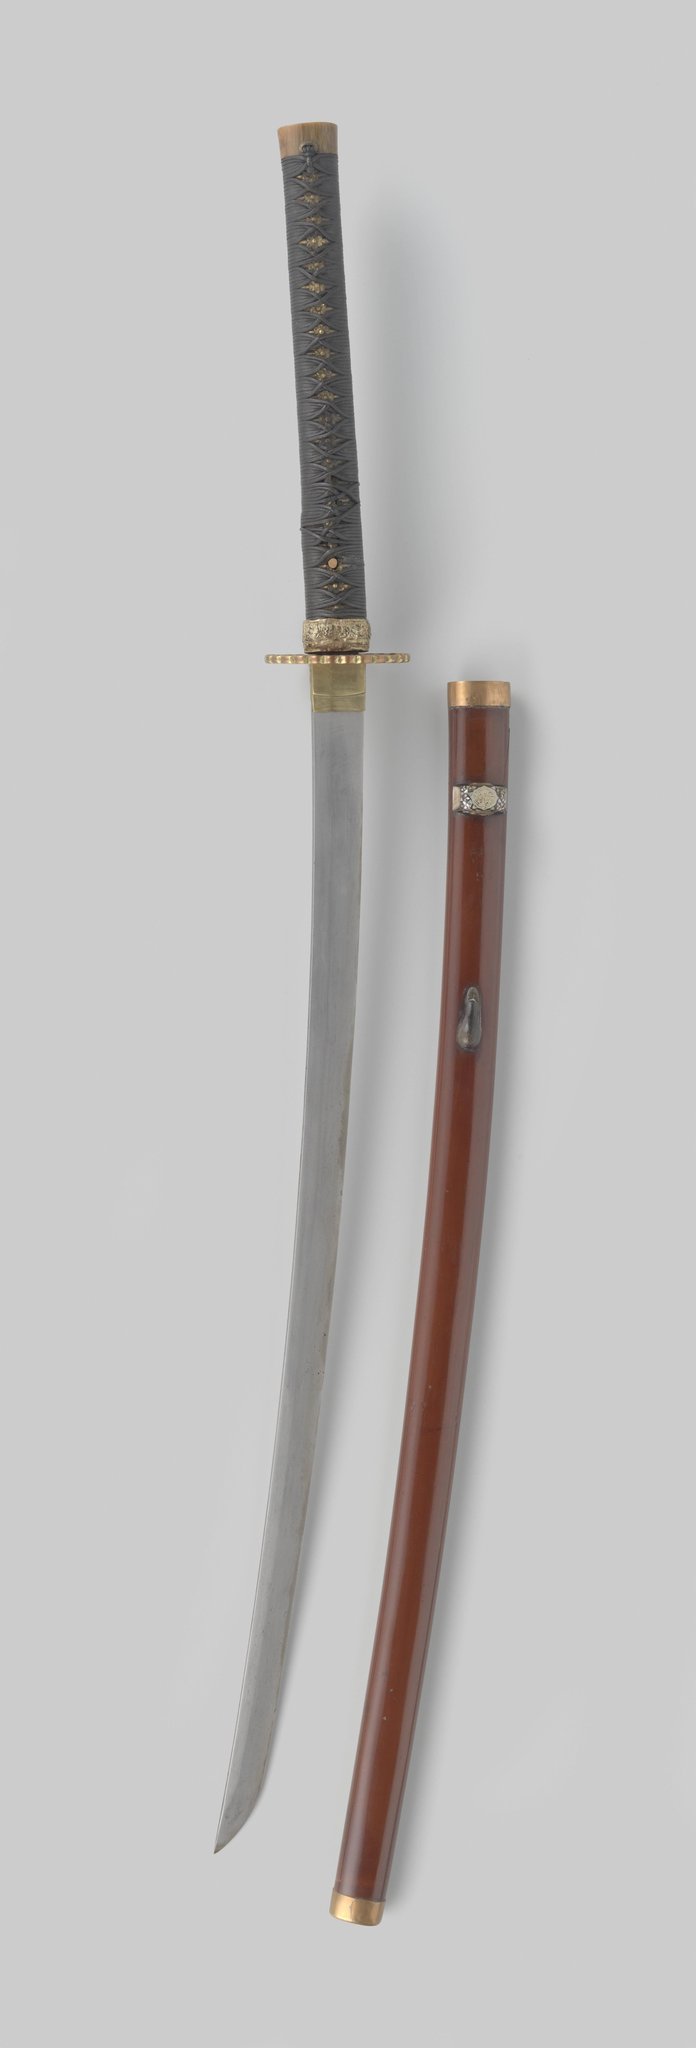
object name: katana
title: Sabel behorend bij wapenrek van Cornelis Tromp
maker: Anonymous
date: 1650-1679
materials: copper, wood, horn, mother of pearl, silk, steel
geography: north vietnam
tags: cornelis tromp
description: Arms collection of Cornelis Tromp. These weapons were kept at the Amsterdam home of Cornelis Tromp. The collection included contemporary weapons of exceptional quality and several exotic weapons acquired for their curiosity value. Tromp probably received many of these weapons as gifts during his patrols of the Mediterranean Sea and in the Baltic.